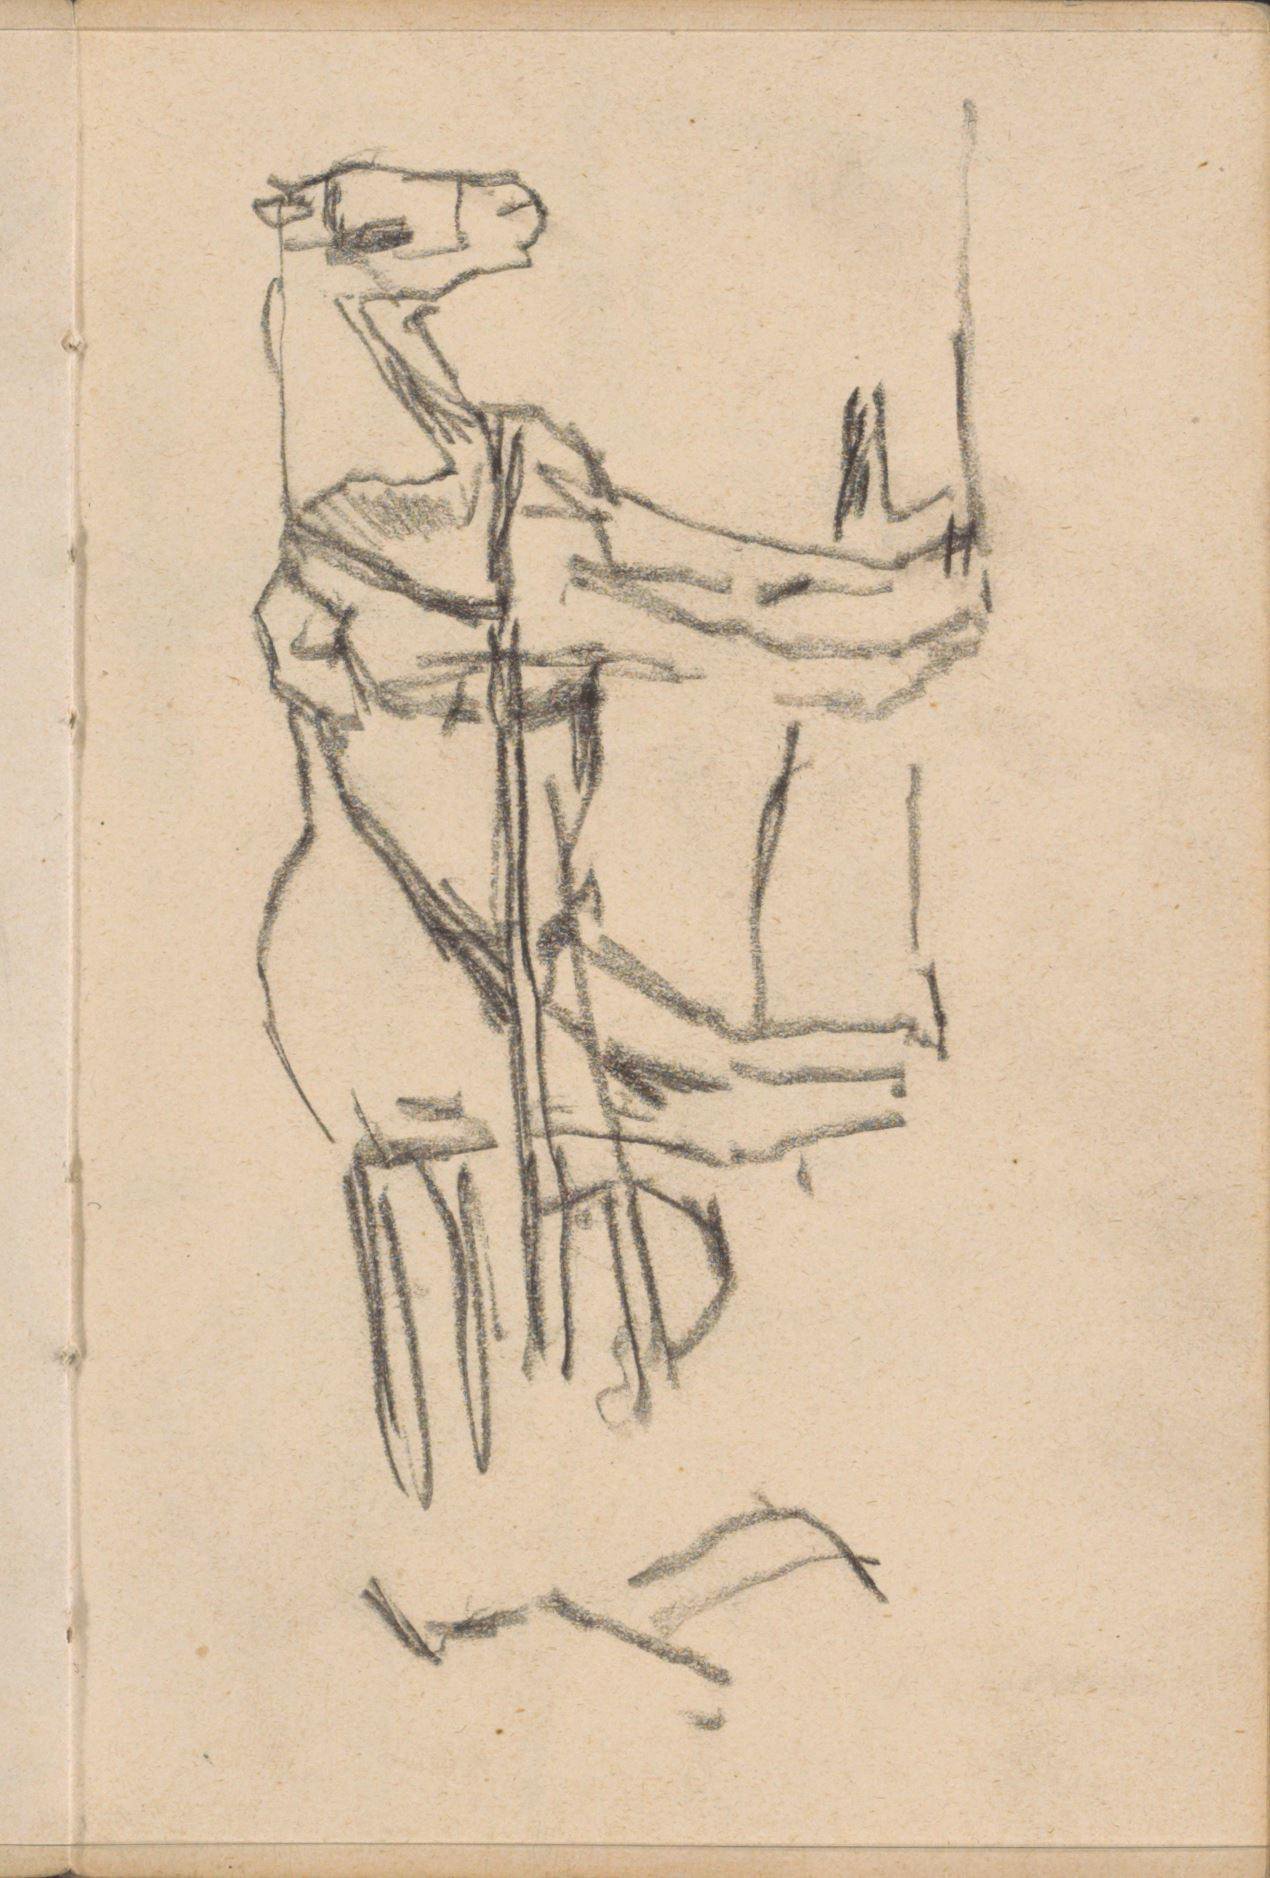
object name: sketchbook leaf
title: Aangespannen paard, mogelijk op de Dam in Amsterdam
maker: george hendrik breitner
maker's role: draughtsman, painter, print maker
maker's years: 1857-1923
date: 1909-1912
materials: chalk, paper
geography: amsterdam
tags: four-wheeled vehicle drawn by one animal, horse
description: Aangespannen paard met oogkleppen, mogelijk op de Dam in Amsterdam. Pagina 14 uit een schetsboek met 46 bladen vervaardigd te Amsterdam.